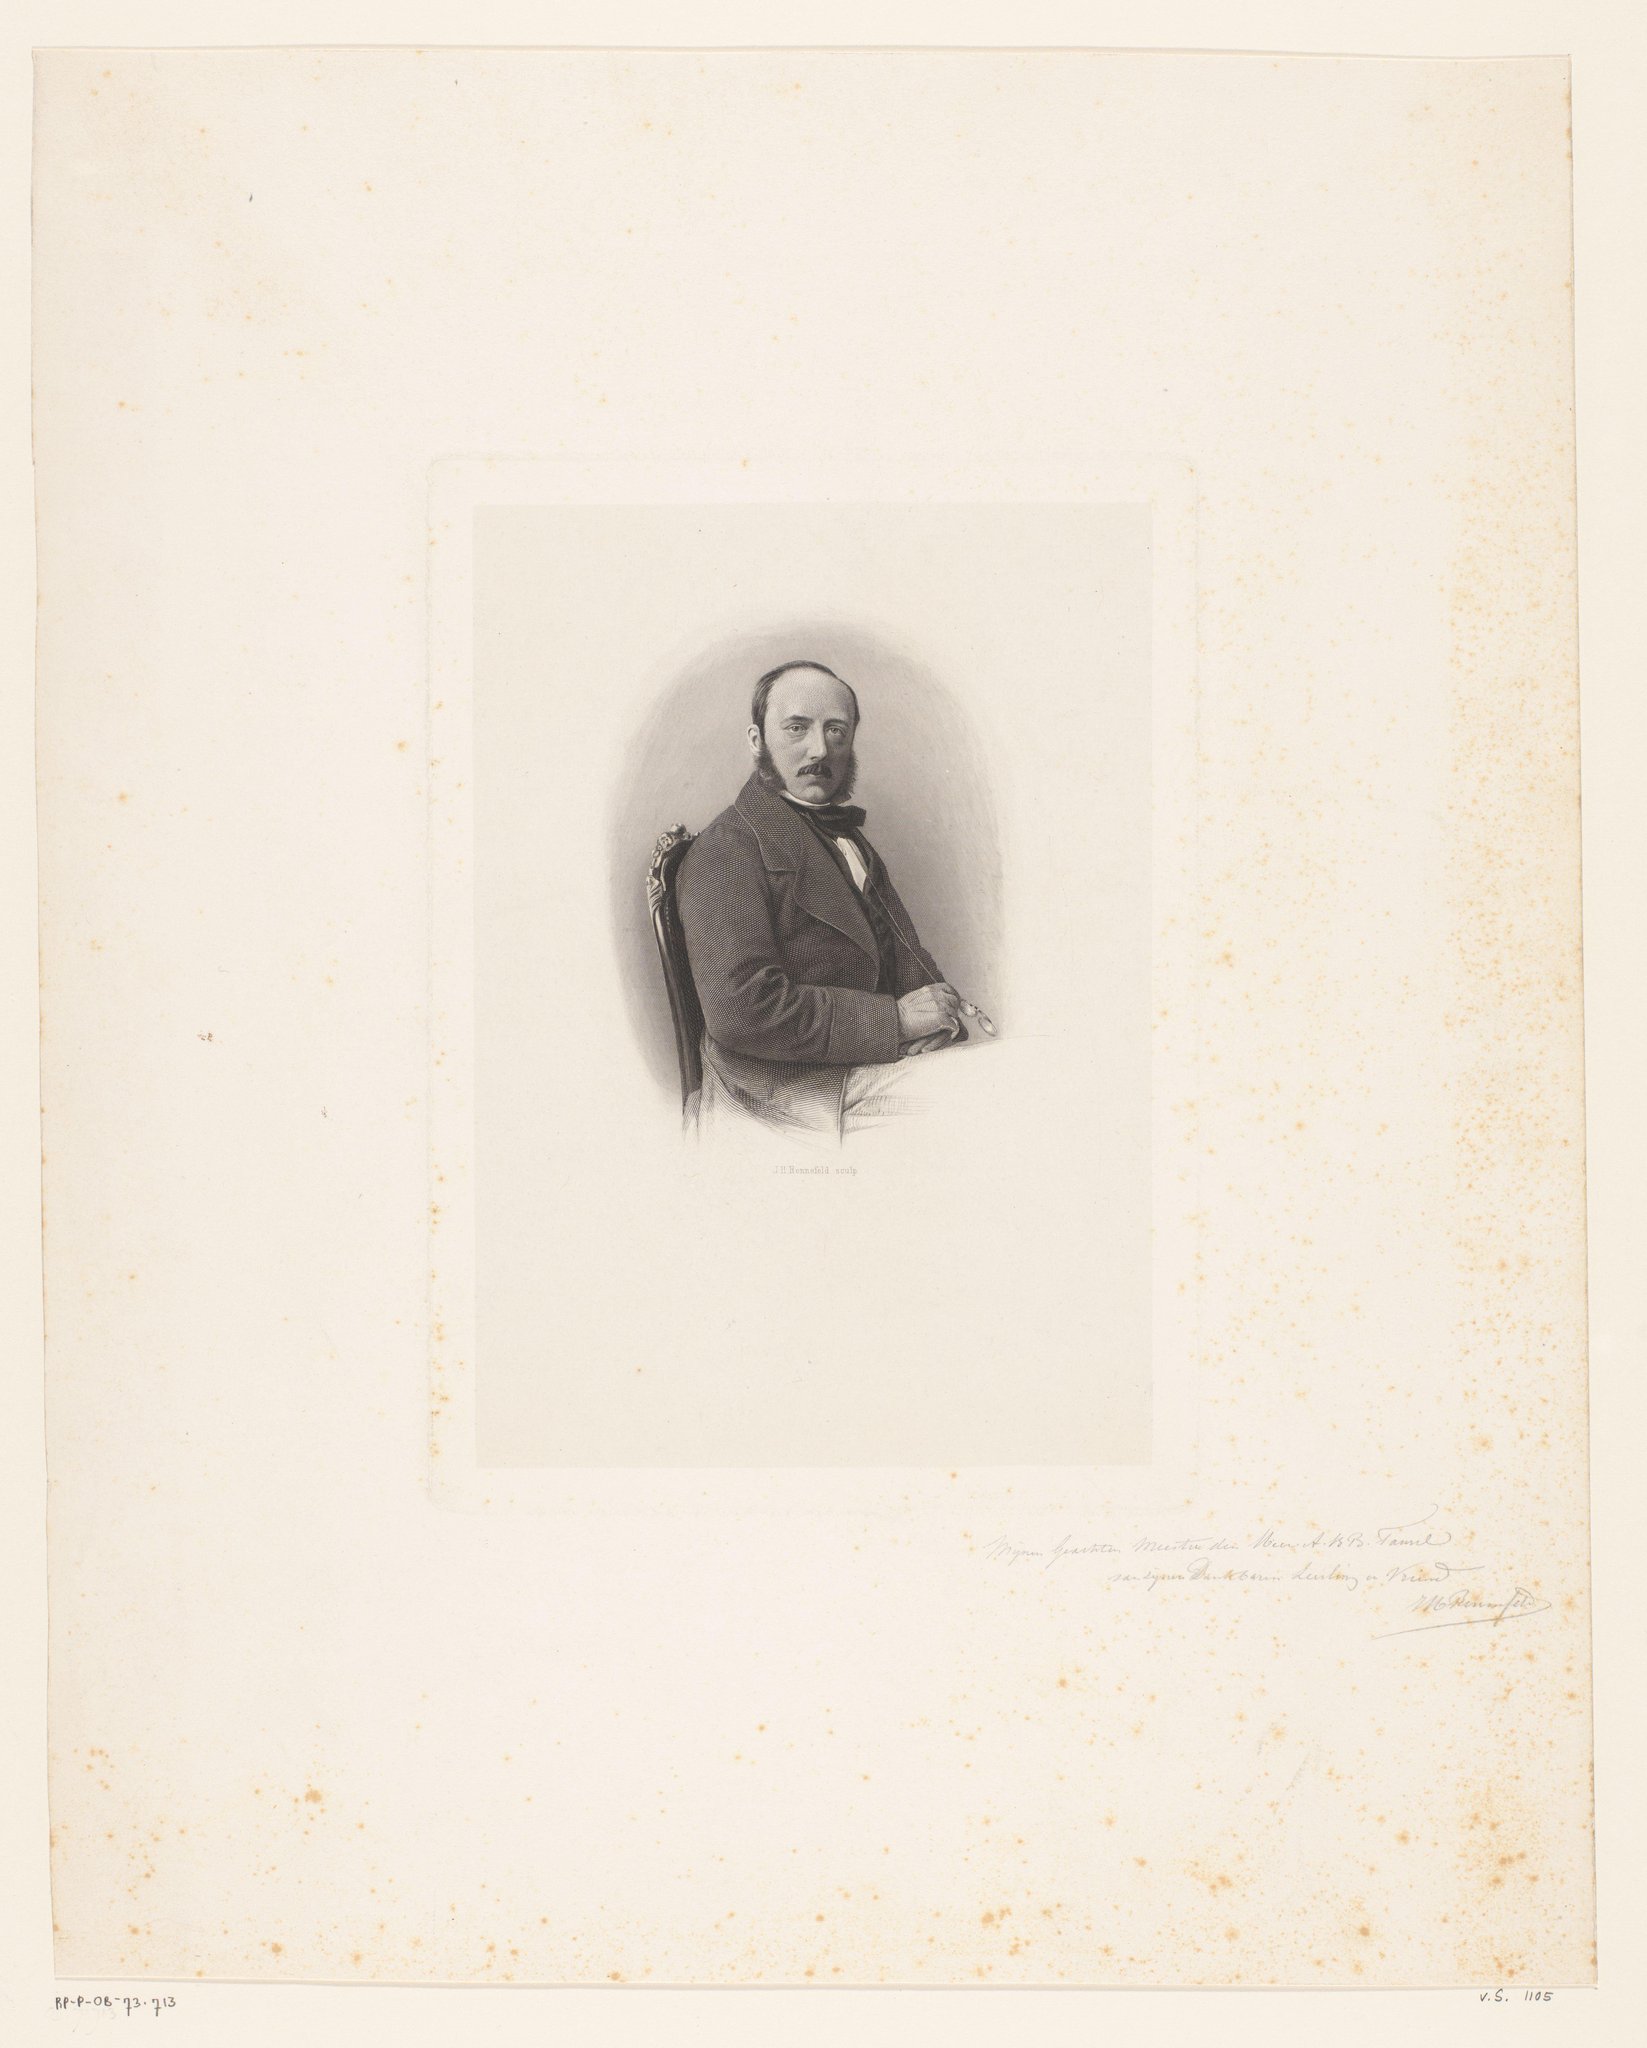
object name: print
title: Portret van Gerrit de Clercq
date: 1845-1857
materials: paper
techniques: roulette, engraving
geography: amsterdam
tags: paris, amsterdam, print maker, draughtsman, benoit taurel, eyeglasses, spectacles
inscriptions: inscription: ‘Mijnen Geachten Meester den Mr A.B.B. Taurel / van zijnen Dankbaren leerling en Vrind / Mr Rennefeld’, collector's mark: Lugt 964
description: Portret van de jurist, schrijver en secretaris Gerrit de Clercq. In zijn hand een lorgnet.